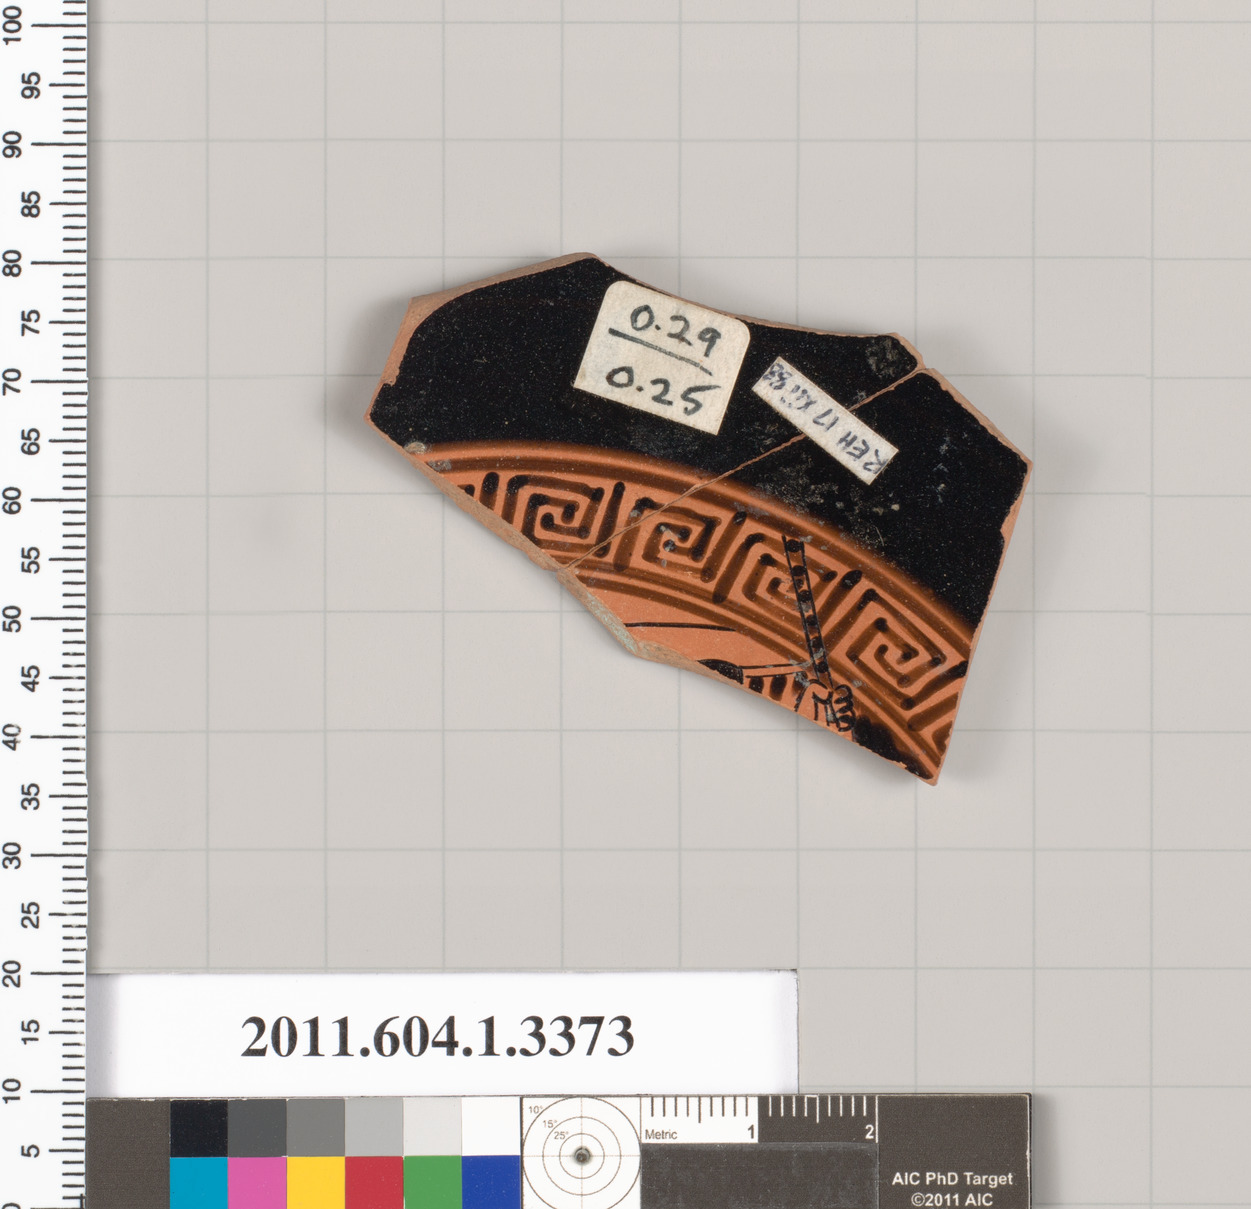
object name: kylix fragment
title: Terracotta fragment of a kylix (drinking cup)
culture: greek, attic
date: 480-470 BCE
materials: terracotta